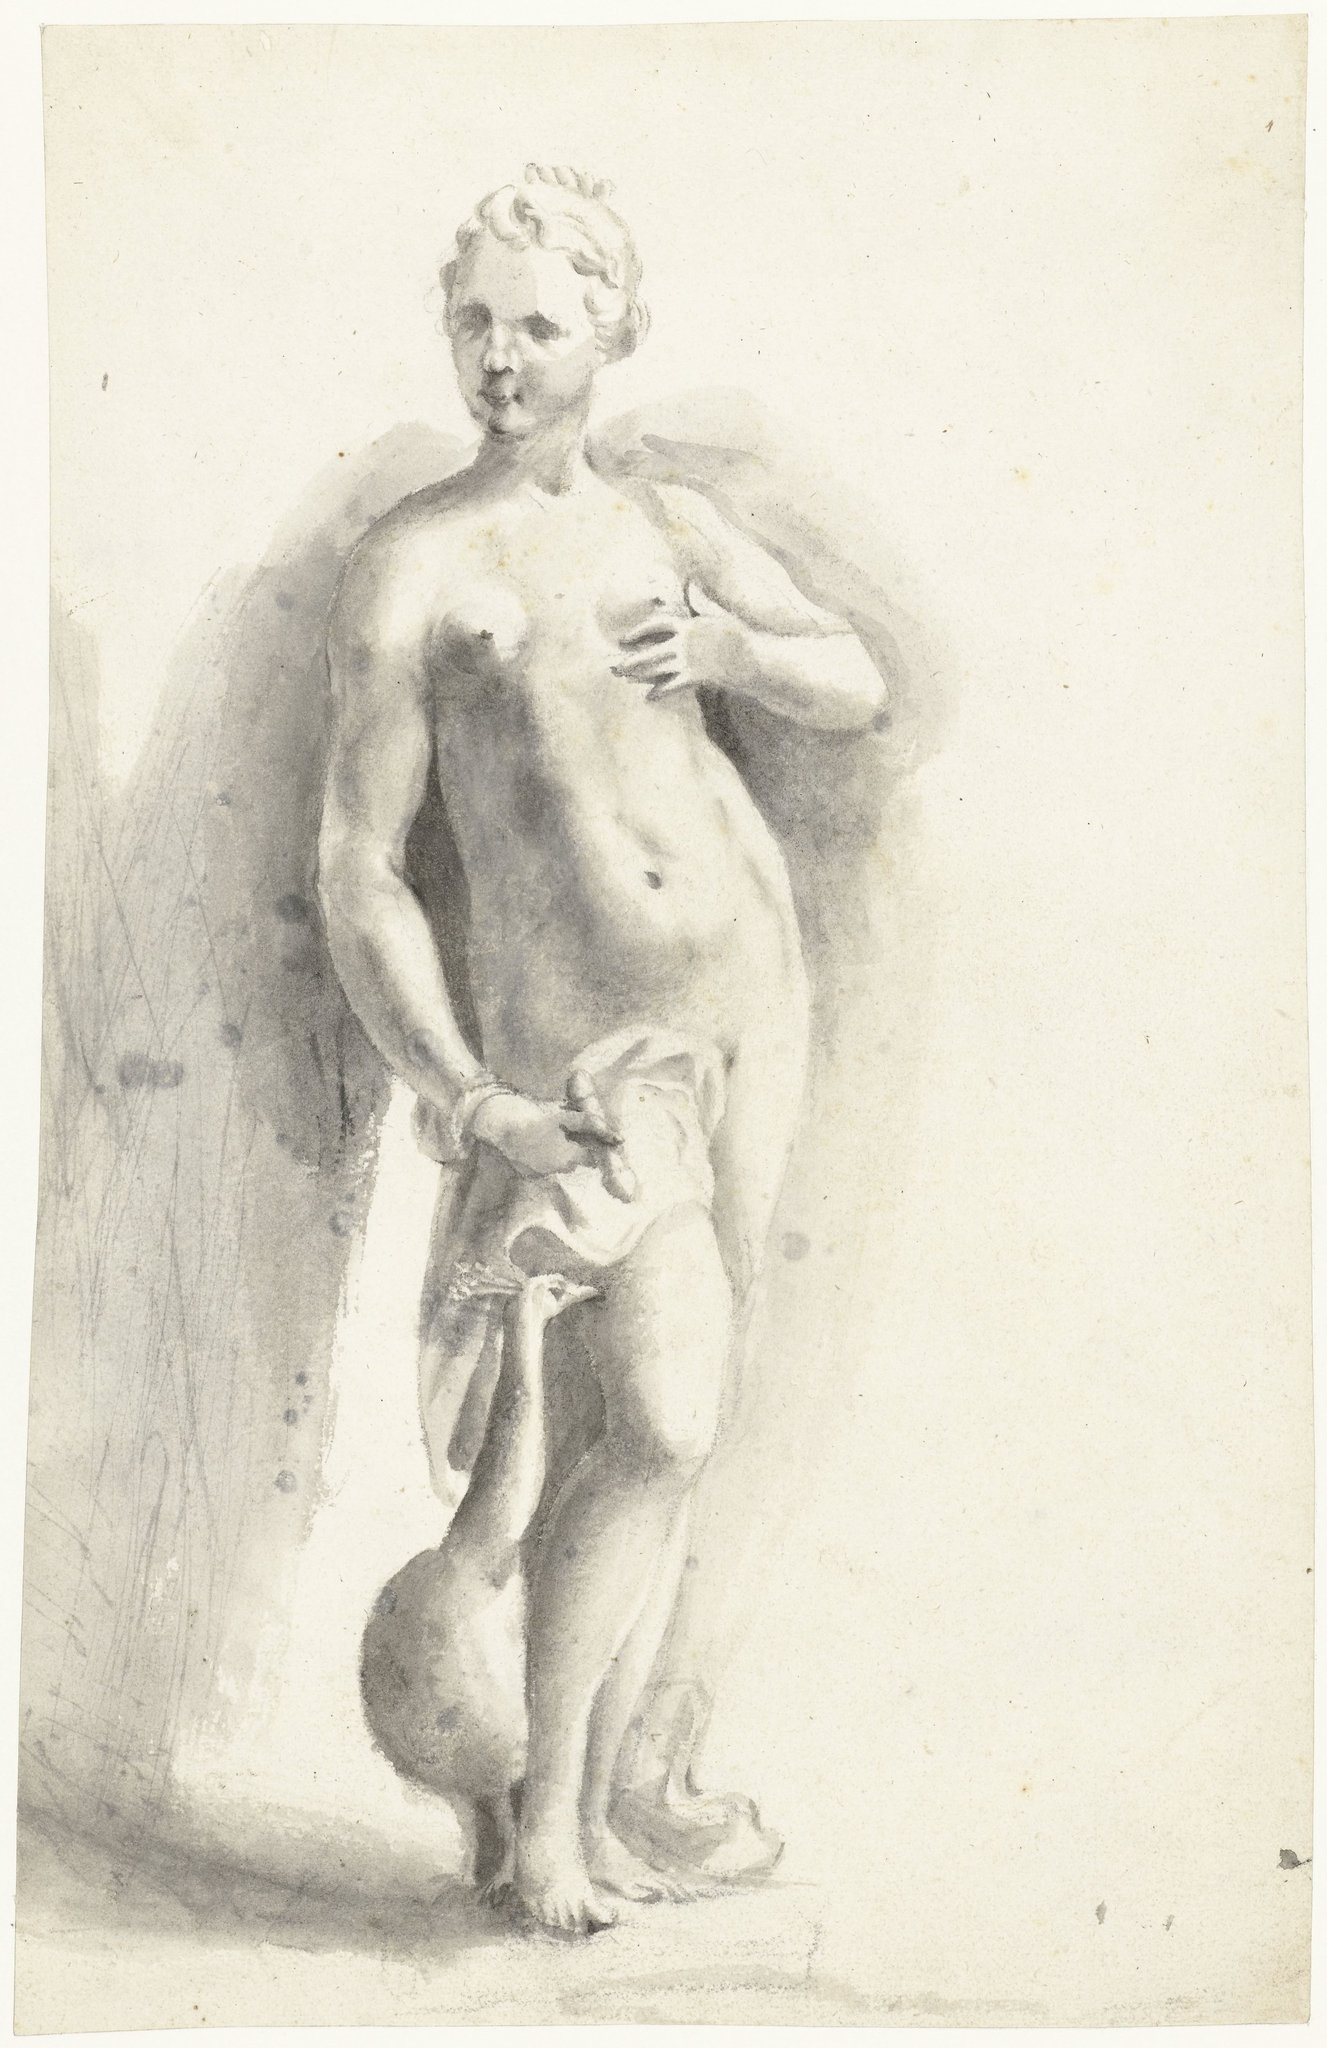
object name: drawing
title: Beeld van Juno en de pauw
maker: moses ter borch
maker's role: draughtsman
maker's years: 1645-1667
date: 1657-1658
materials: chalk, ink, paper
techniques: brush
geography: zwolle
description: Tekening naar afgietsel van Juno en de pauw. Het beeldhouwwerk dat Moses heeft getekend was gebaseerd op de Juno en de pauw meestal toegeschreven aan de werkplaats van de 16e eeuwse Venetiaanse beeldhouwer Alessandro Vittorio.